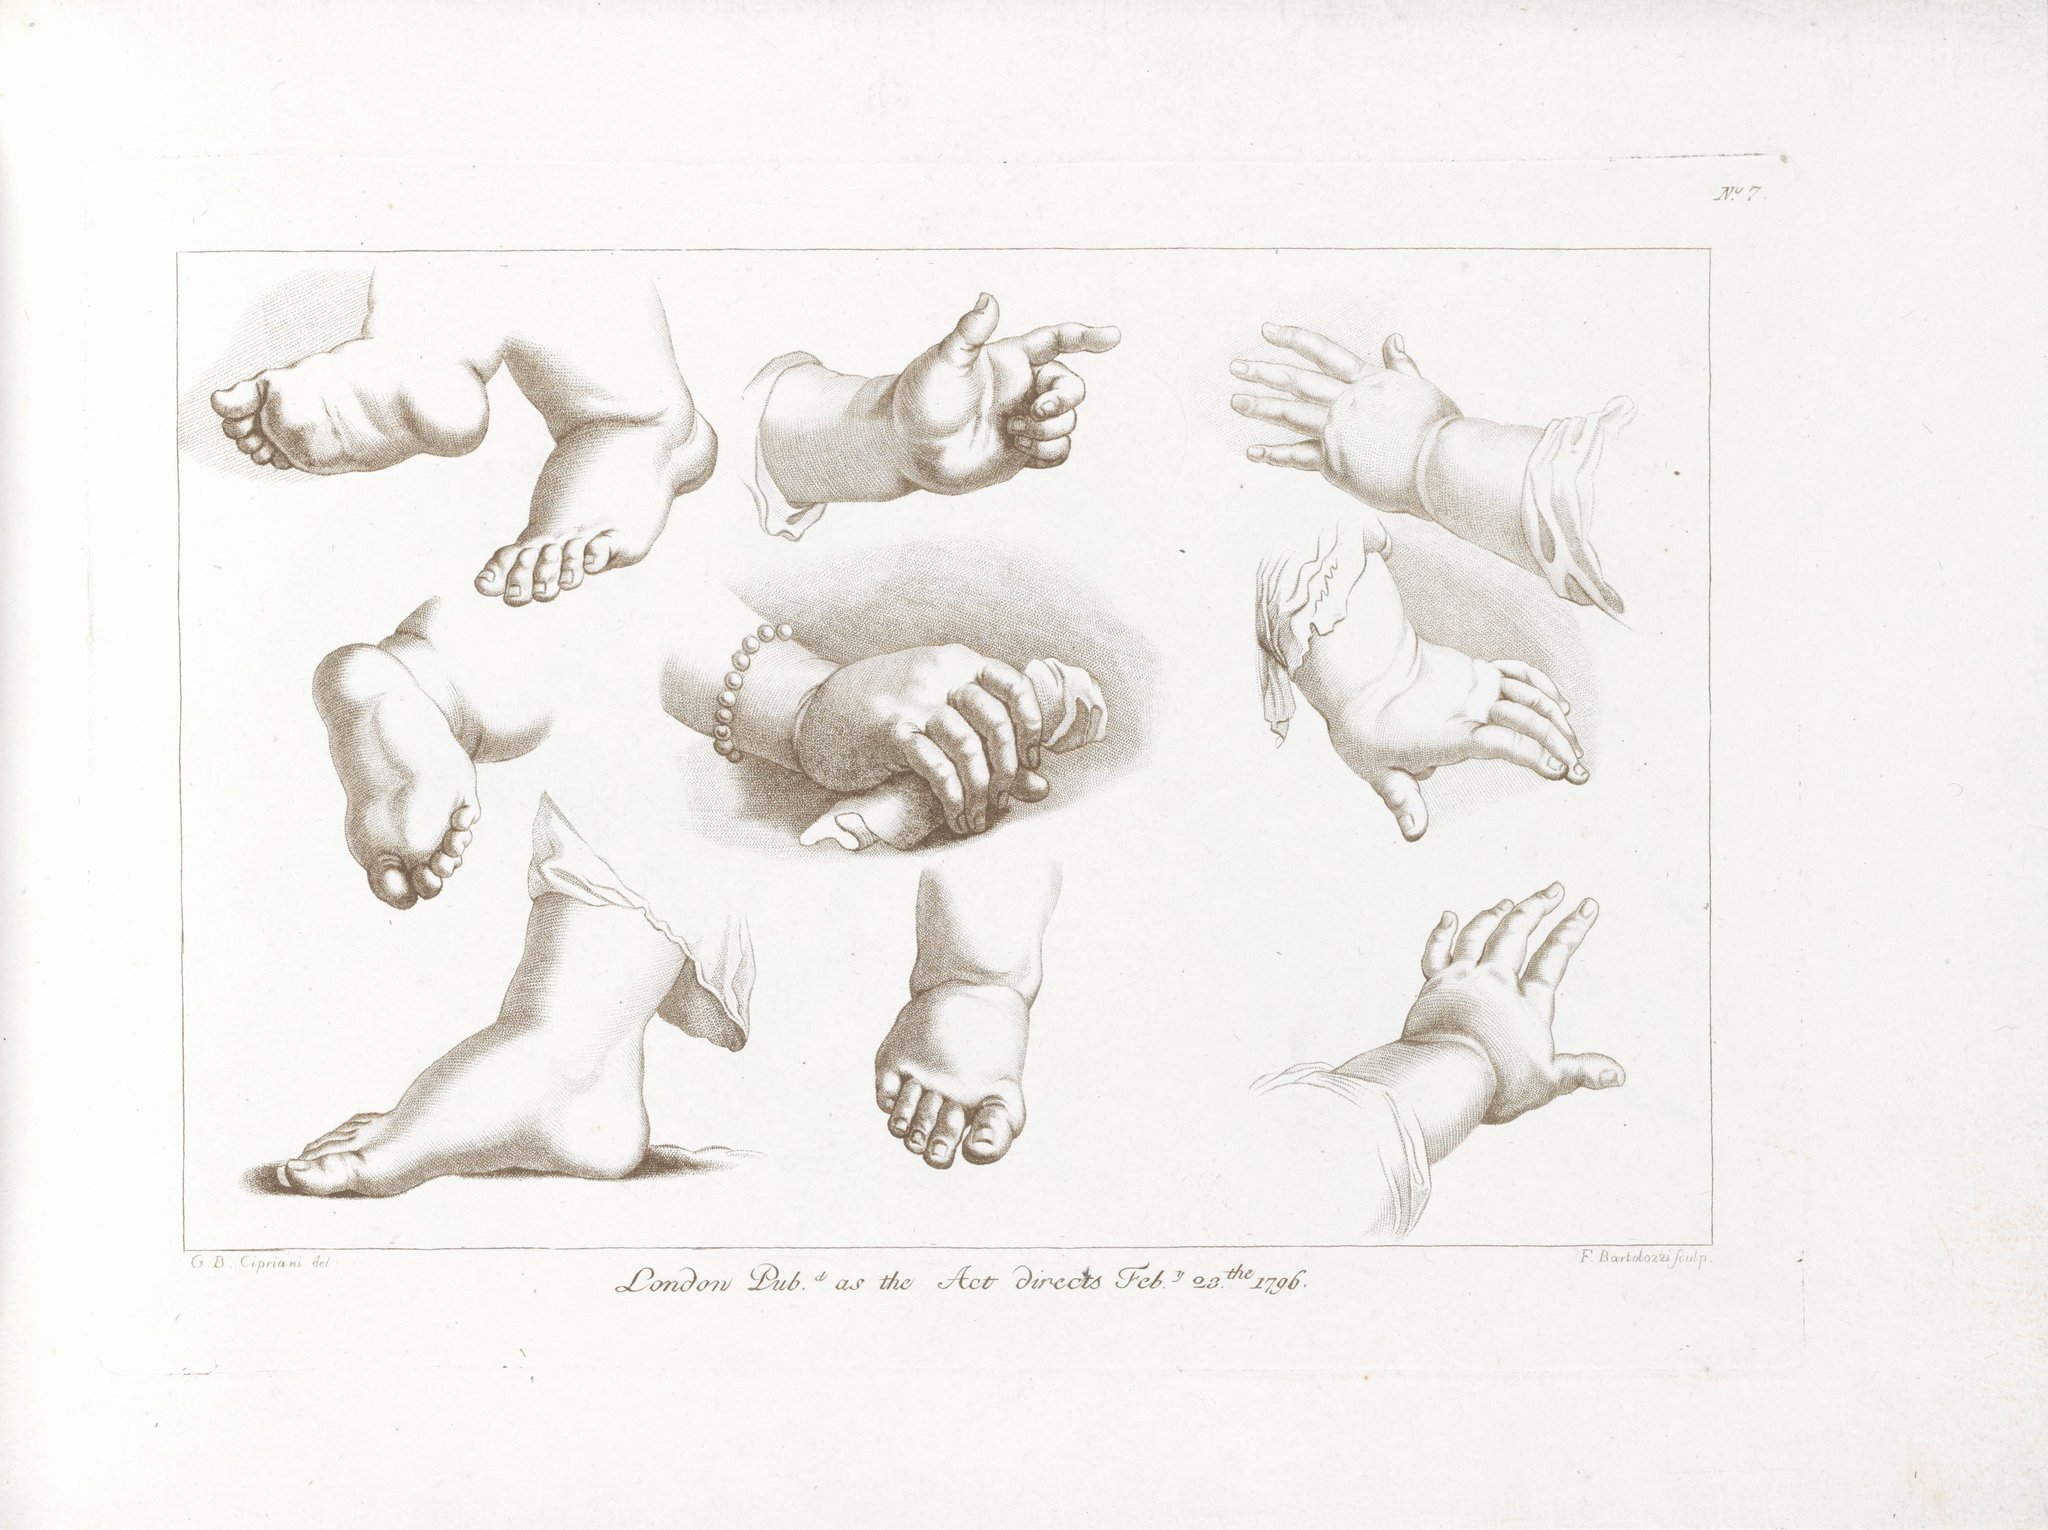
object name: print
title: Vijf handen en vijf voeten van kinderen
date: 1796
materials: paper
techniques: etching, engraving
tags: hand, foot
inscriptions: collector's mark: Lugt 2760, collector's mark: Lugt 2228